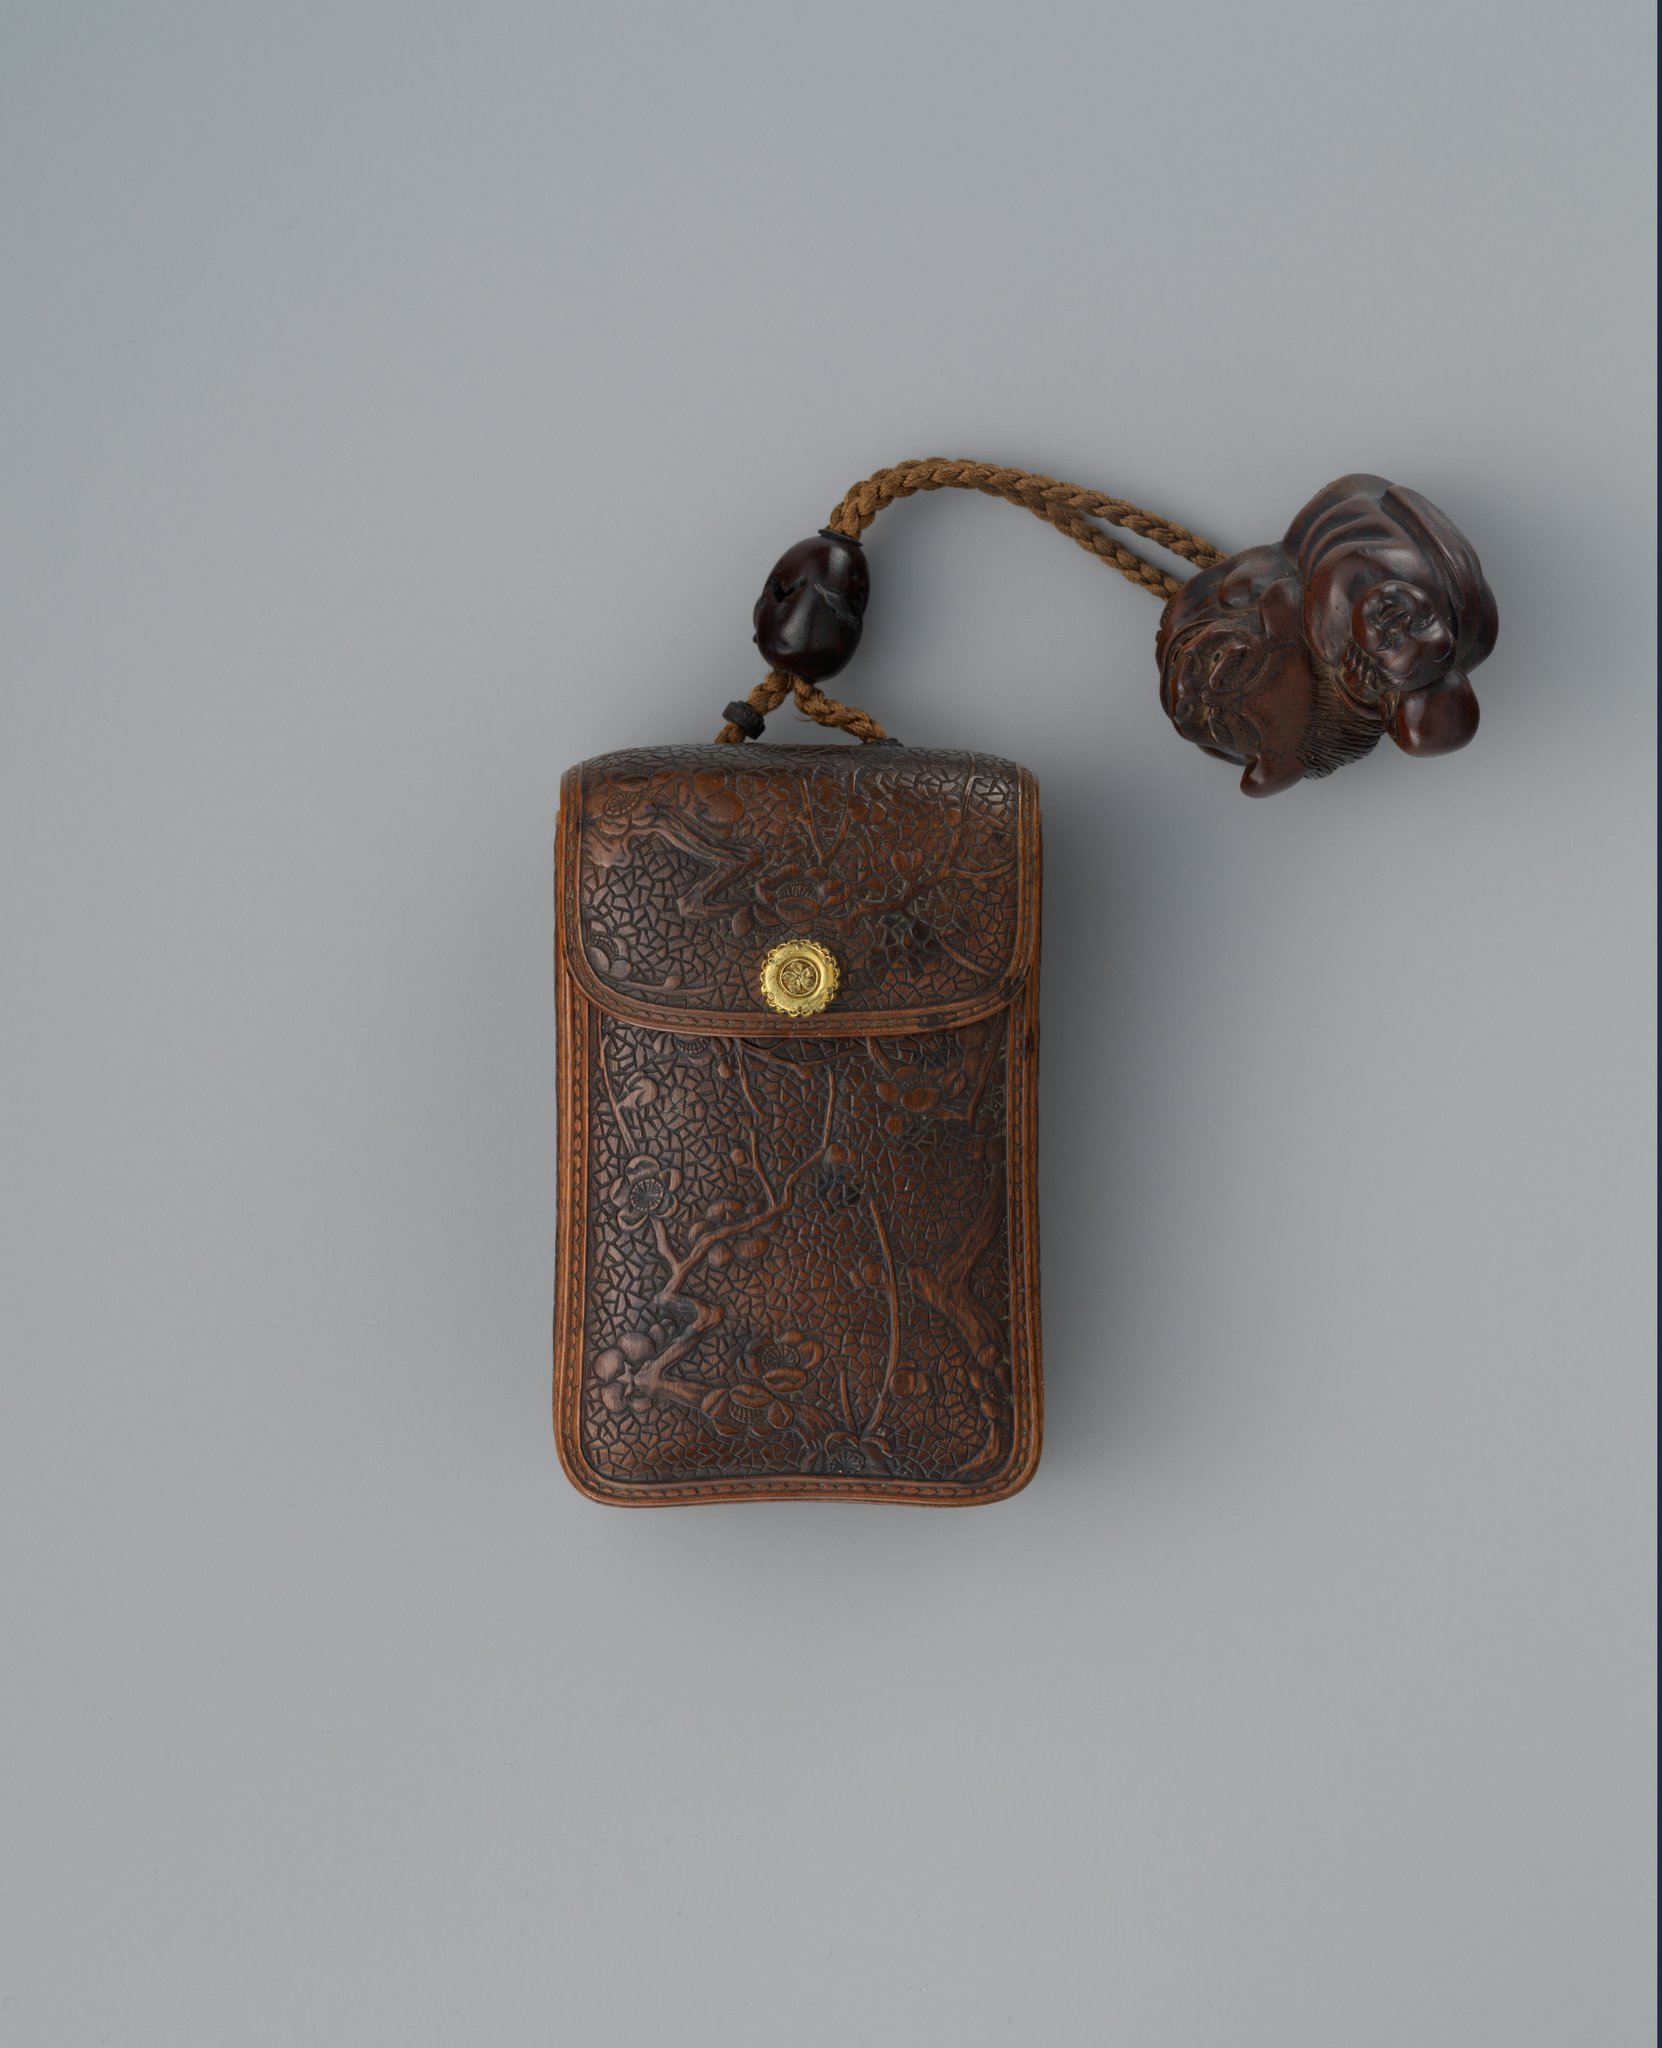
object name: inrō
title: Inrō in the Shape of a Leather Tobacco Case (Tabakoire) with Flowering Plum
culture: japanese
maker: matsuda sukenaga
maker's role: artist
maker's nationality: japanese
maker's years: 1800-1871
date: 1834-1866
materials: lacquer, leather, metal, wood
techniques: carving, gilding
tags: flowers